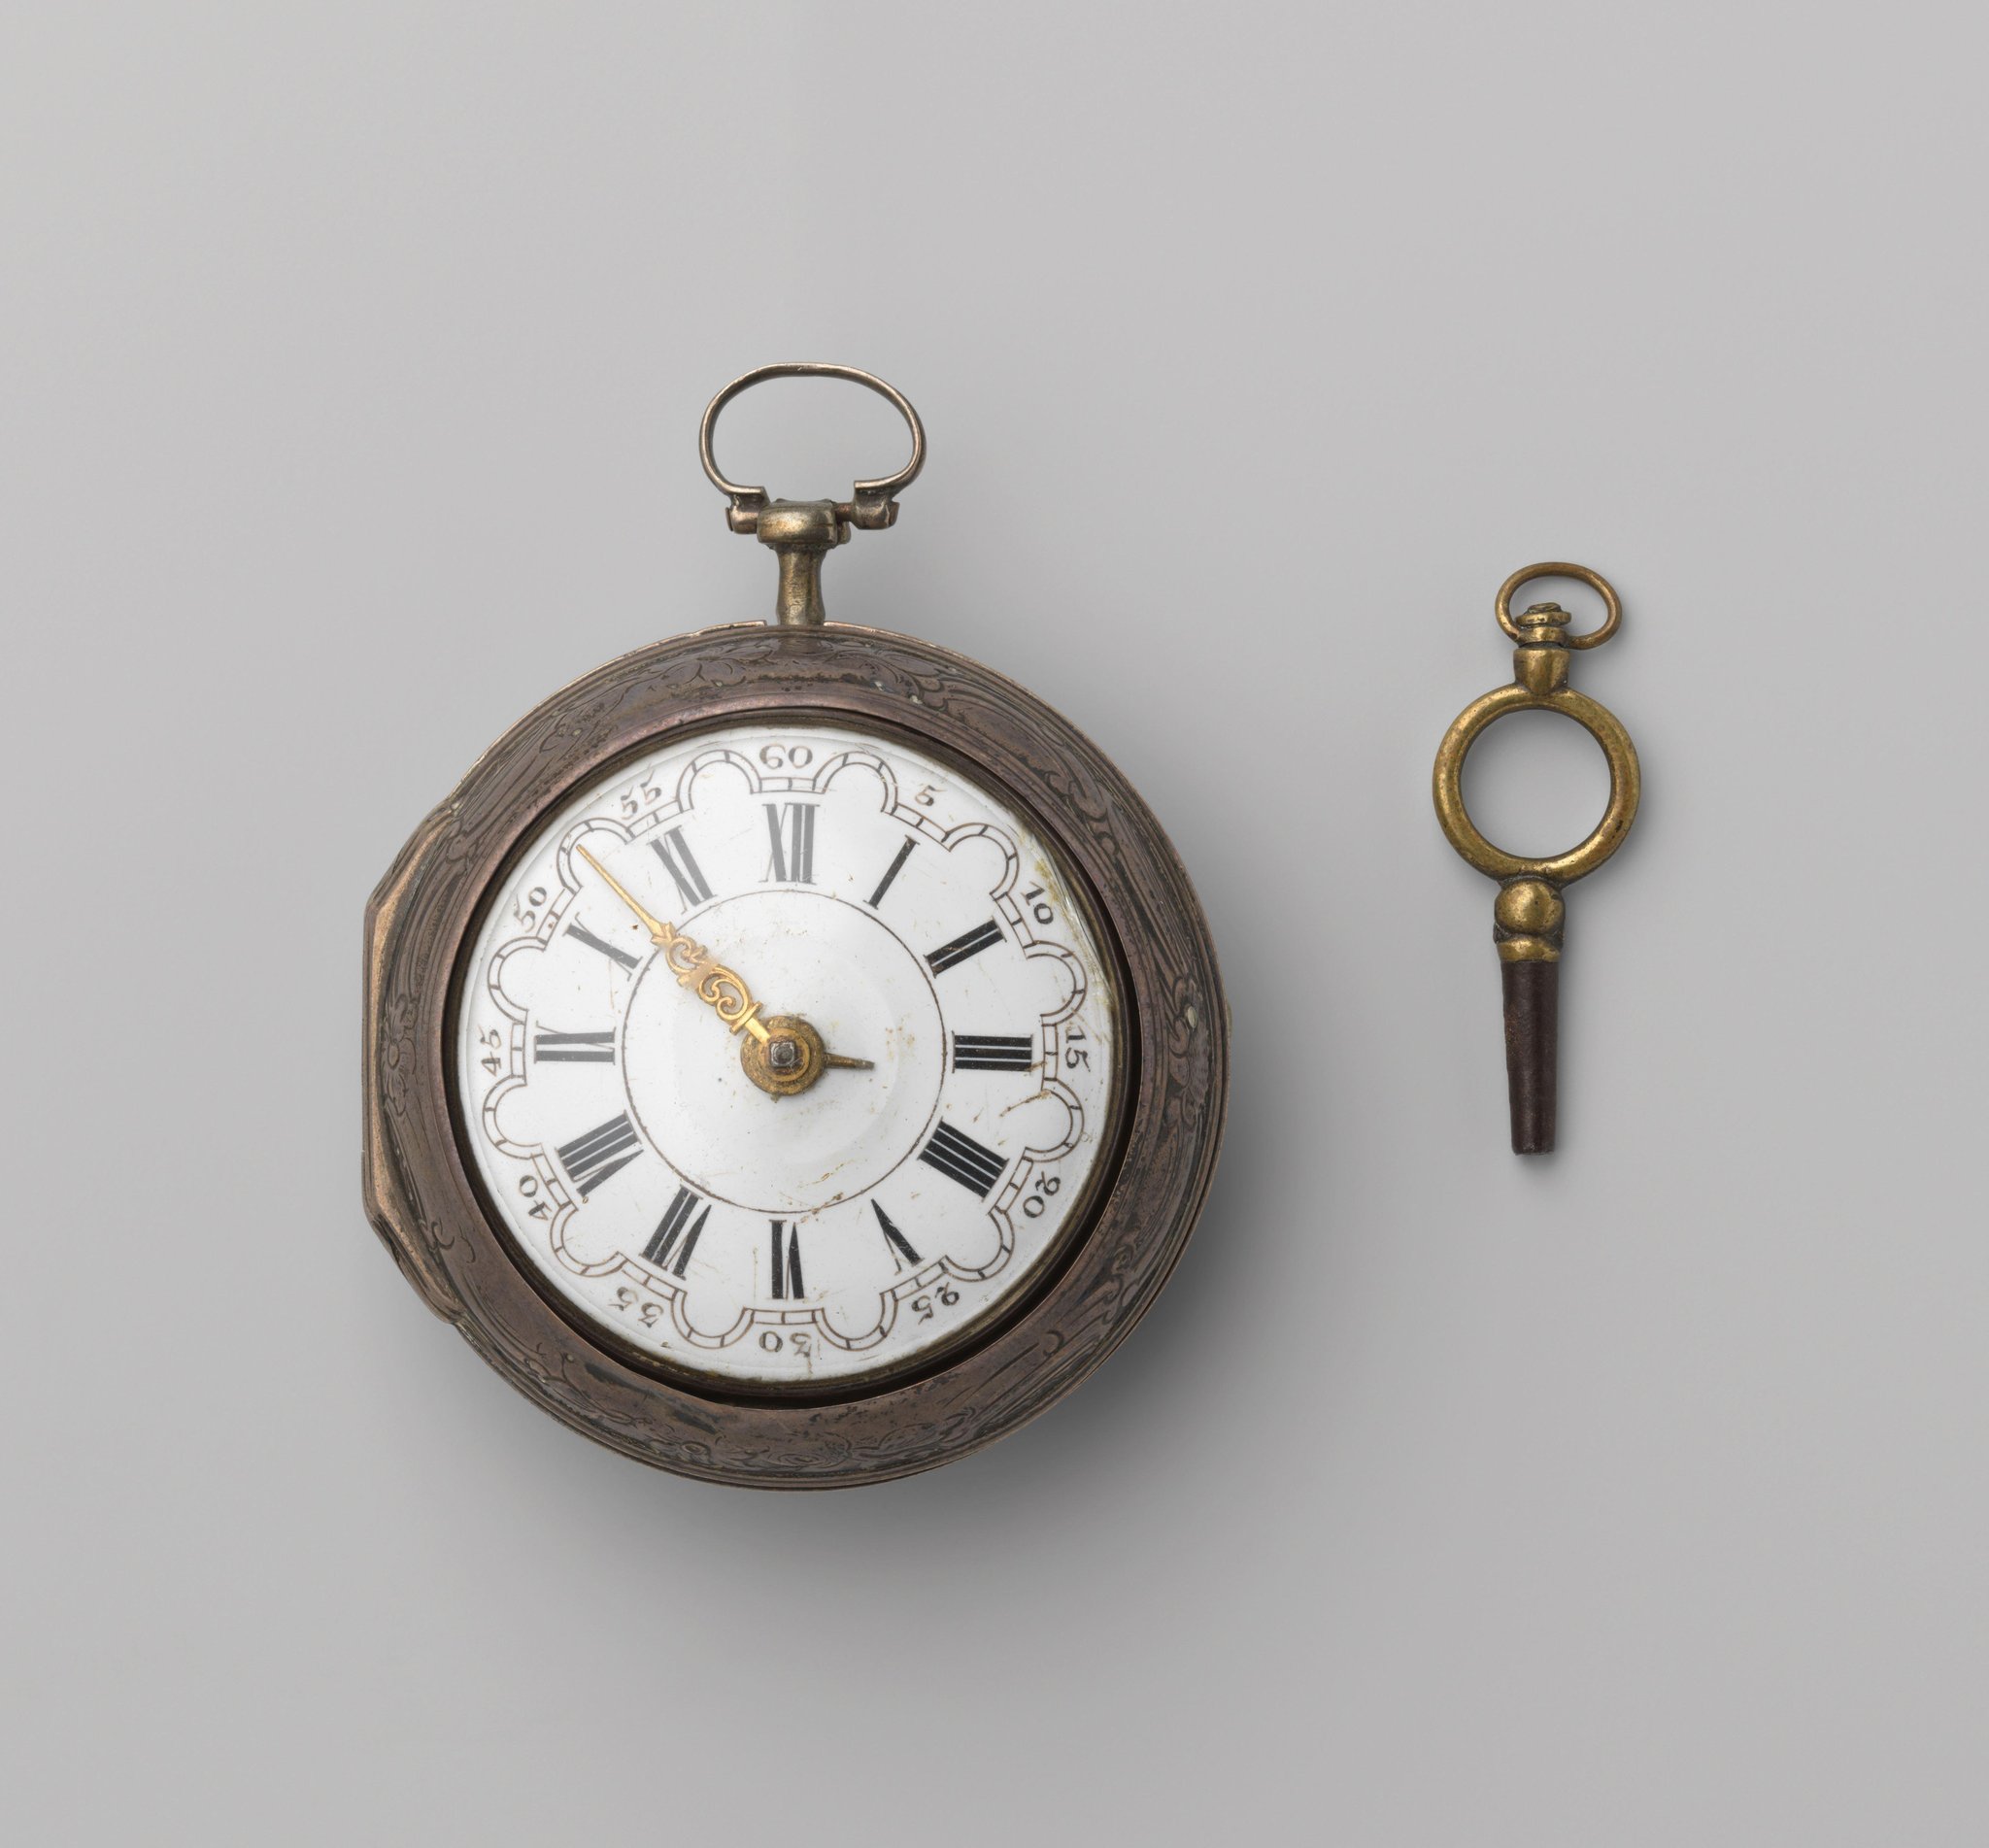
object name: jewellery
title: Horloge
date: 1784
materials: silver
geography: london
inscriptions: mark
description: Horloge met wit geëmailleerde wijzerplaat met romeinse cijfers. De zilveren buitenkast heeft een gedreven voorstelling uit de Romeinse historie (?). Met sleuteltje.